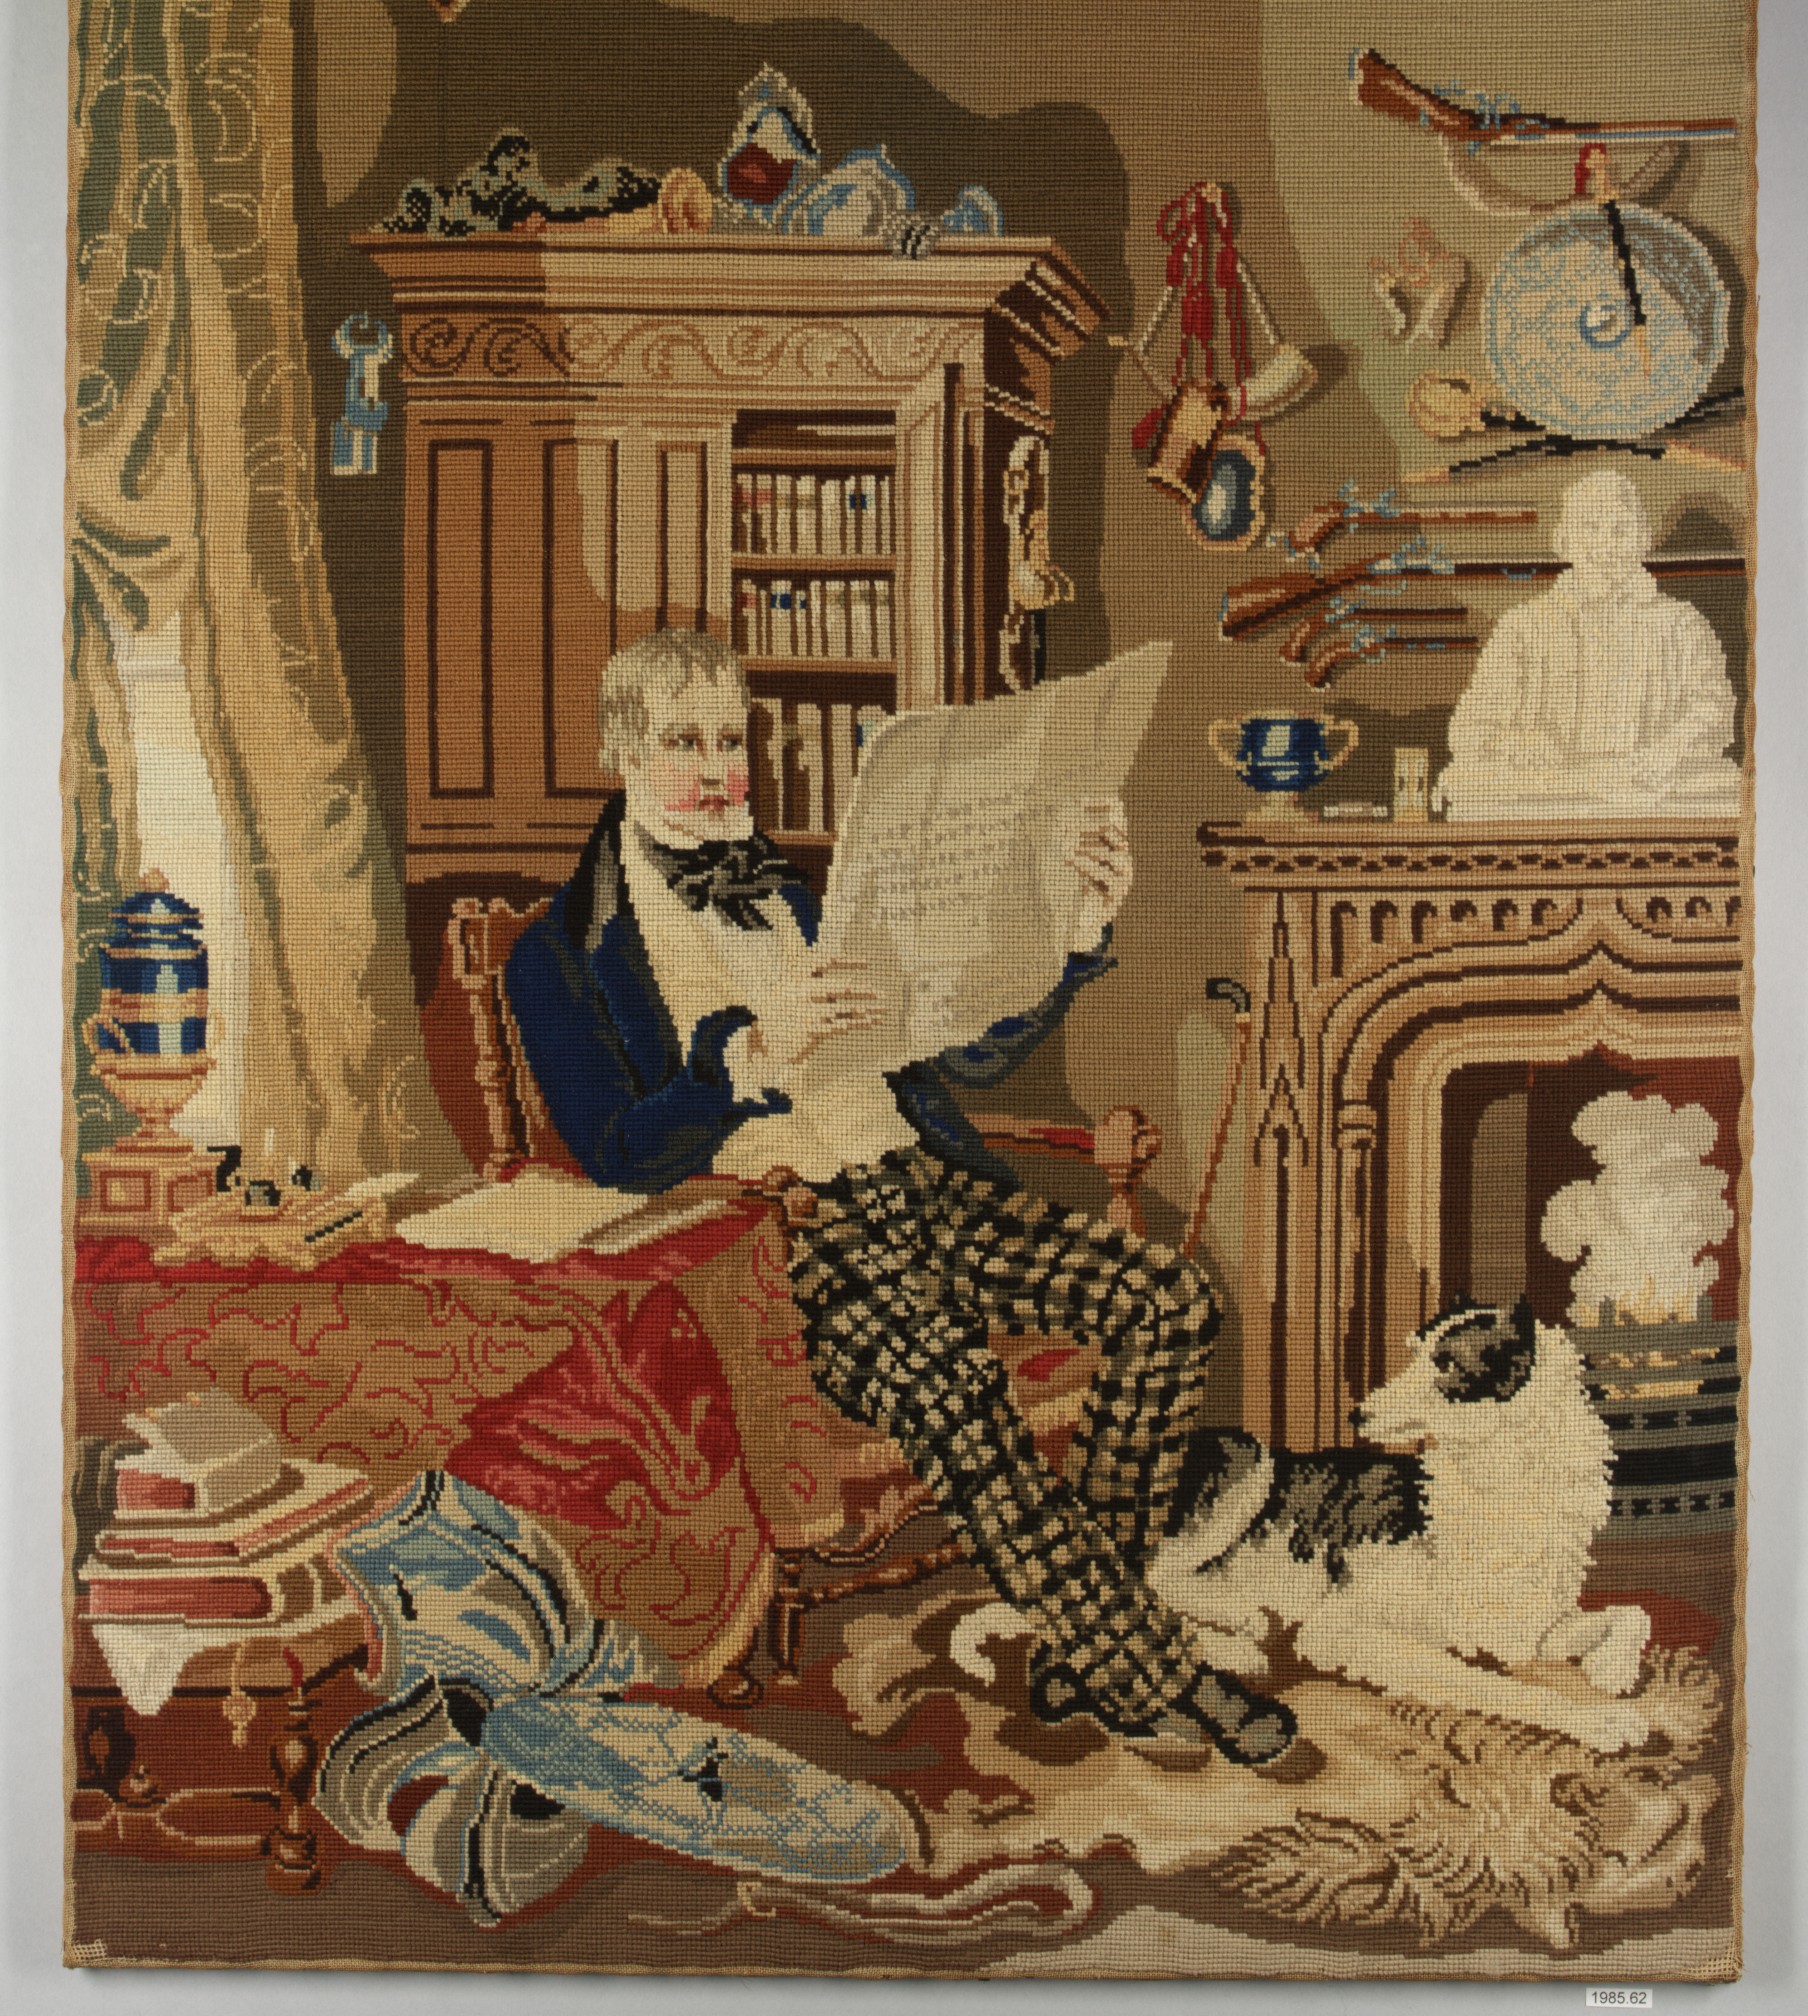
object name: embroidered picture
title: Sir Walter Scott at Abbotsford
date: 1851-1875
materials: canvas, wool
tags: interiors,men,reading,dogs